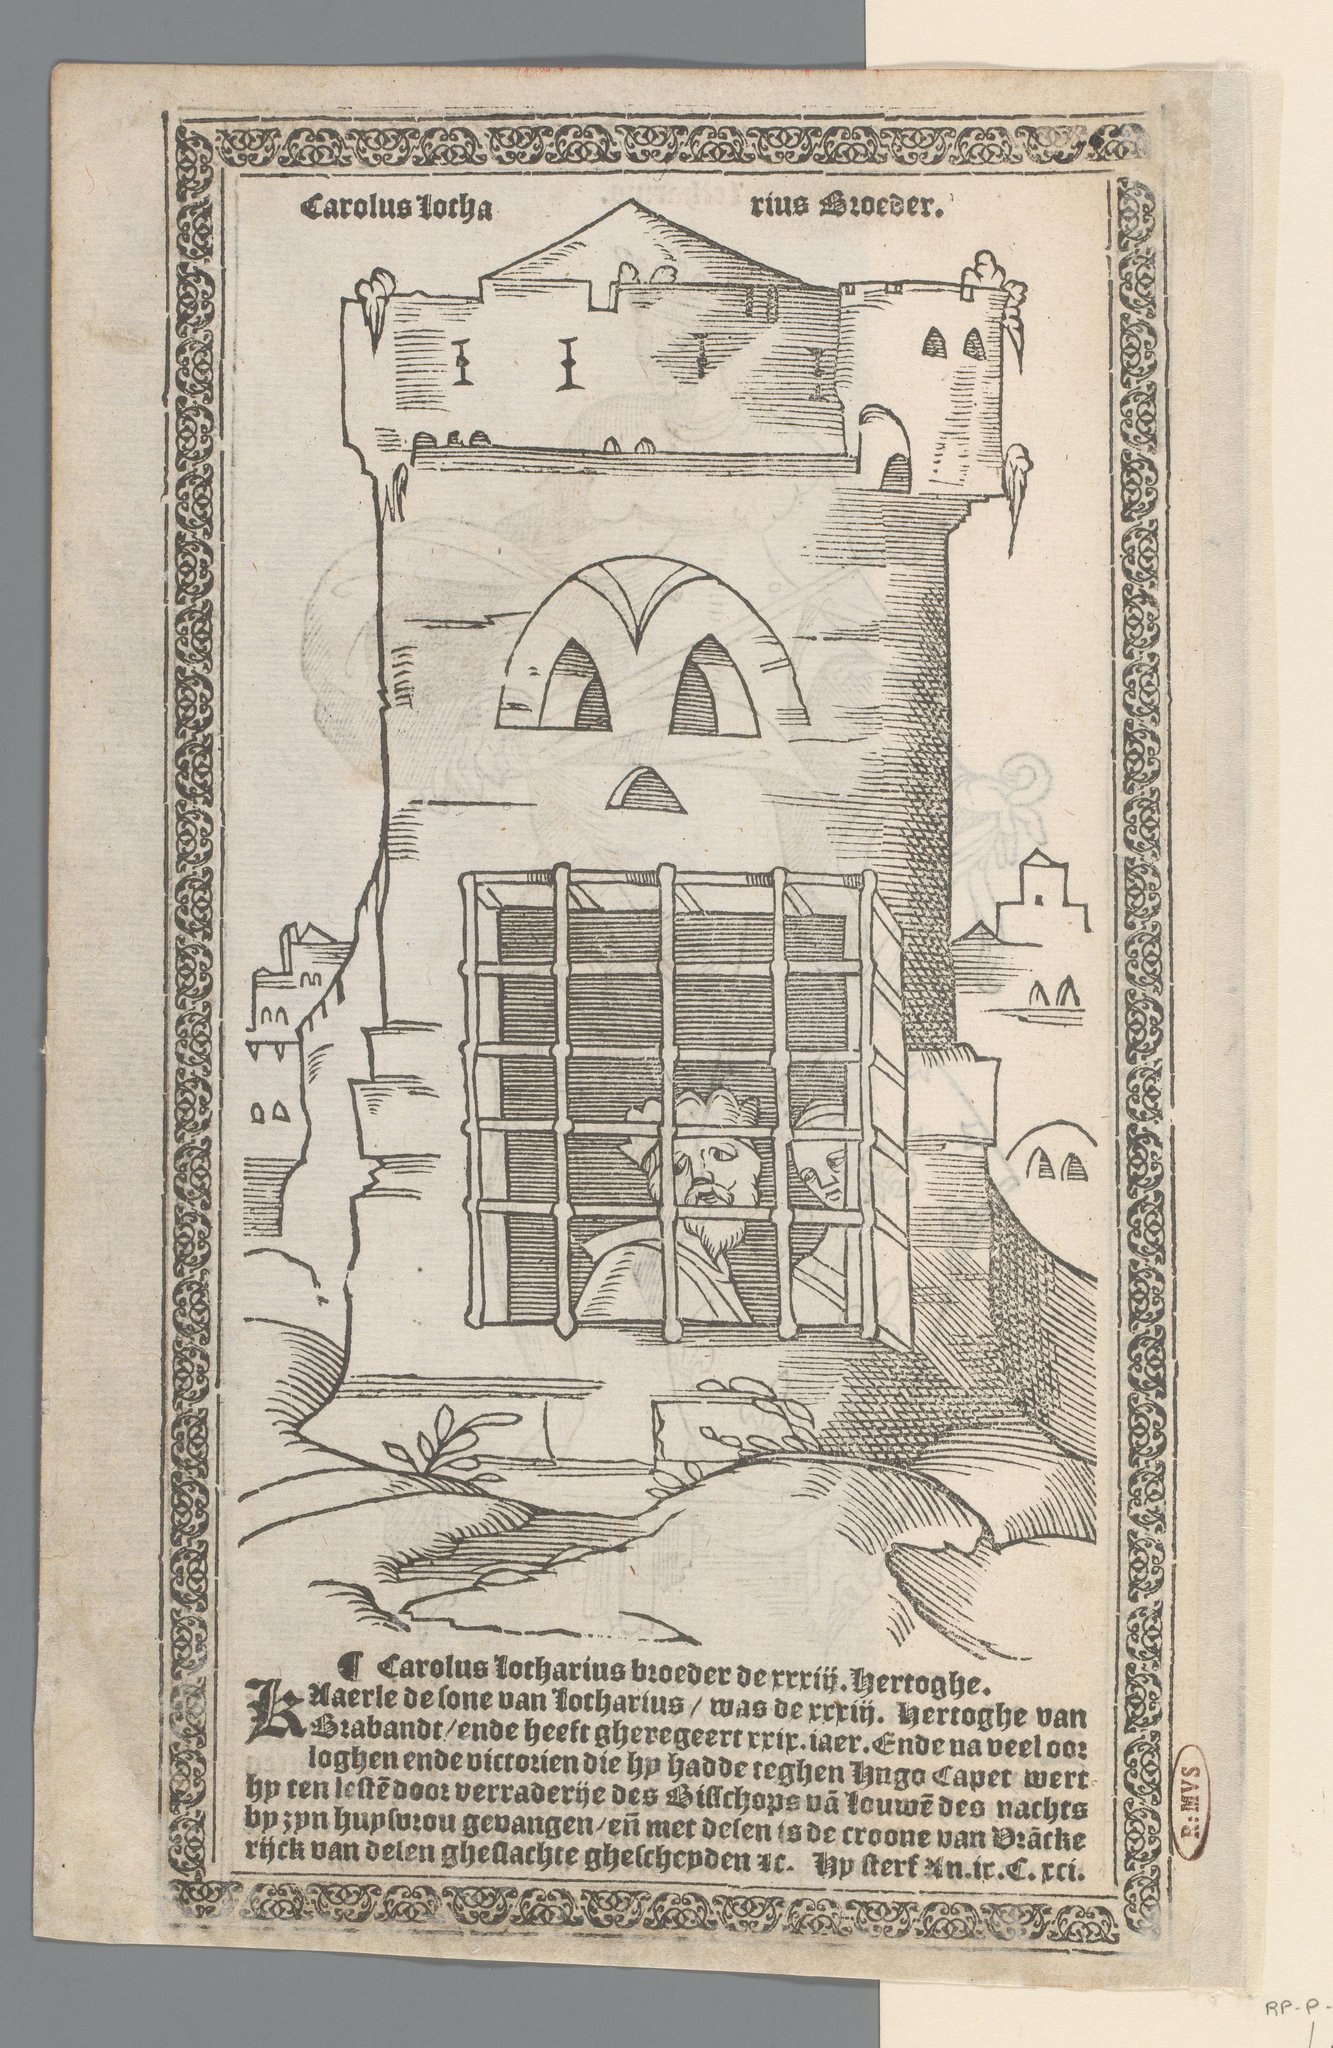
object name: print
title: Karel van Neder-Lotharingen en Adelheid in een kerker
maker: jan molijns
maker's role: print maker, publisher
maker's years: 1498-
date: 1565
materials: paper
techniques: letterpress printing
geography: antwerp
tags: historical persons, prisoner in cell or locked place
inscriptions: collector's mark: Lugt 2228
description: Prent uit: Dit is die afcoemste ende genalogie der hertoghen ende hertoginnen van Brabandt, (...). Antwerpen: Jan Molijns, 1565.